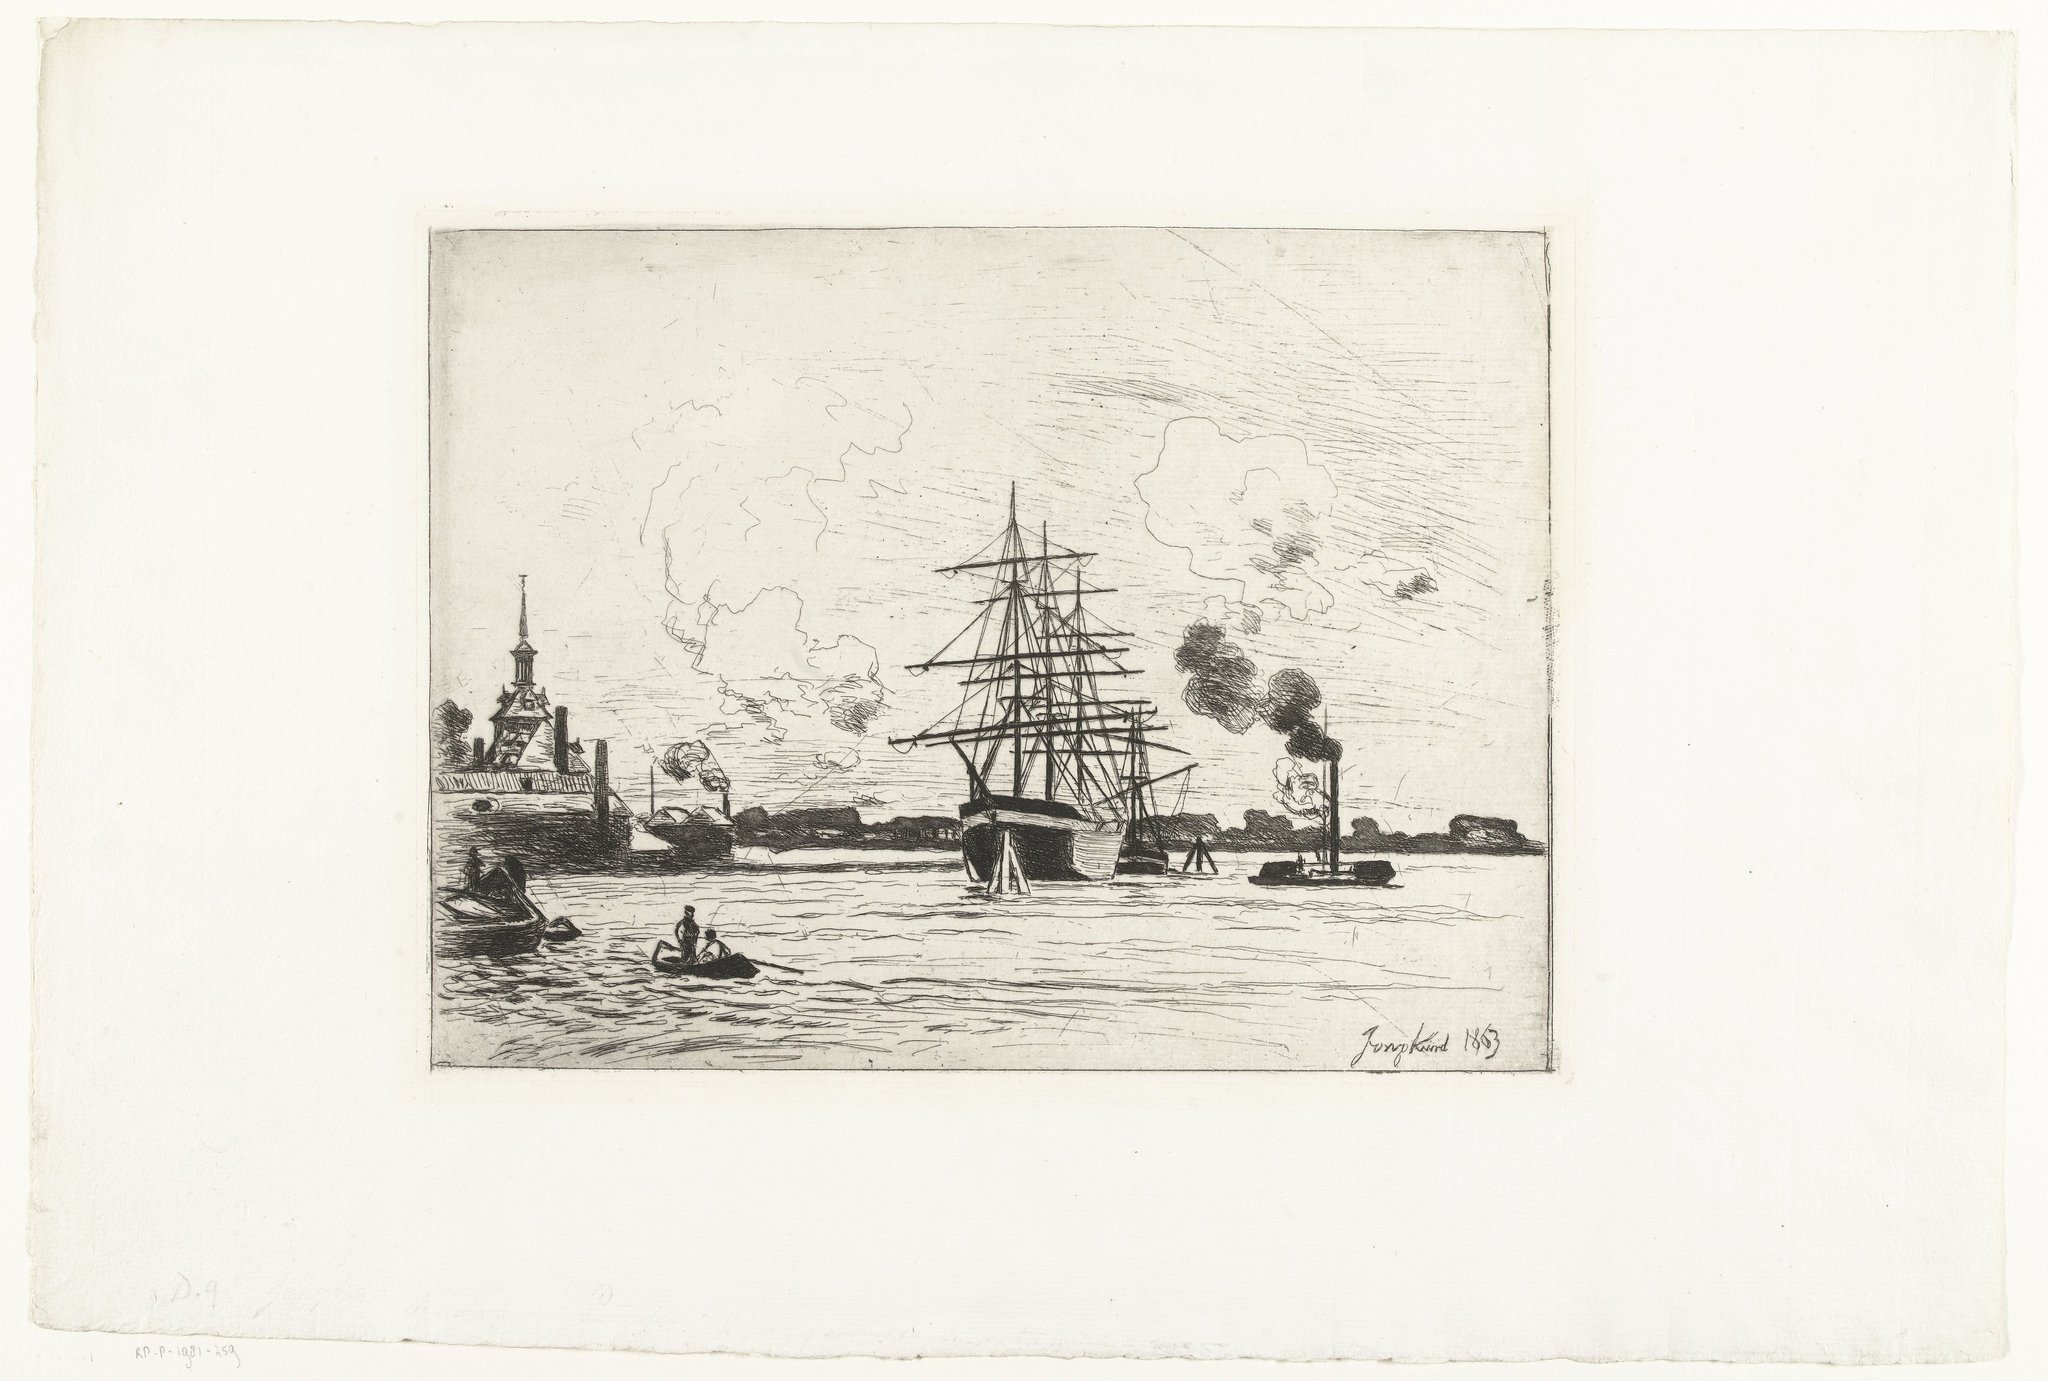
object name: print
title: De haven van Rotterdam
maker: johan barthold jongkind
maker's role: draughtsman, painter, print maker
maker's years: 1819-1891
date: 1863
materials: paper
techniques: etching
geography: rotterdam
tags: harbour, ships (in general), rotterdam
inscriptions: collector's mark: Lugt 2228, collector's mark: Lugt 2760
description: D. 9 expl. in coll. David-Weill (vlg. Sotheby's, Londen, 4-12-'81 nr. 120) draagt aantekening 'Refusée par la societé'.